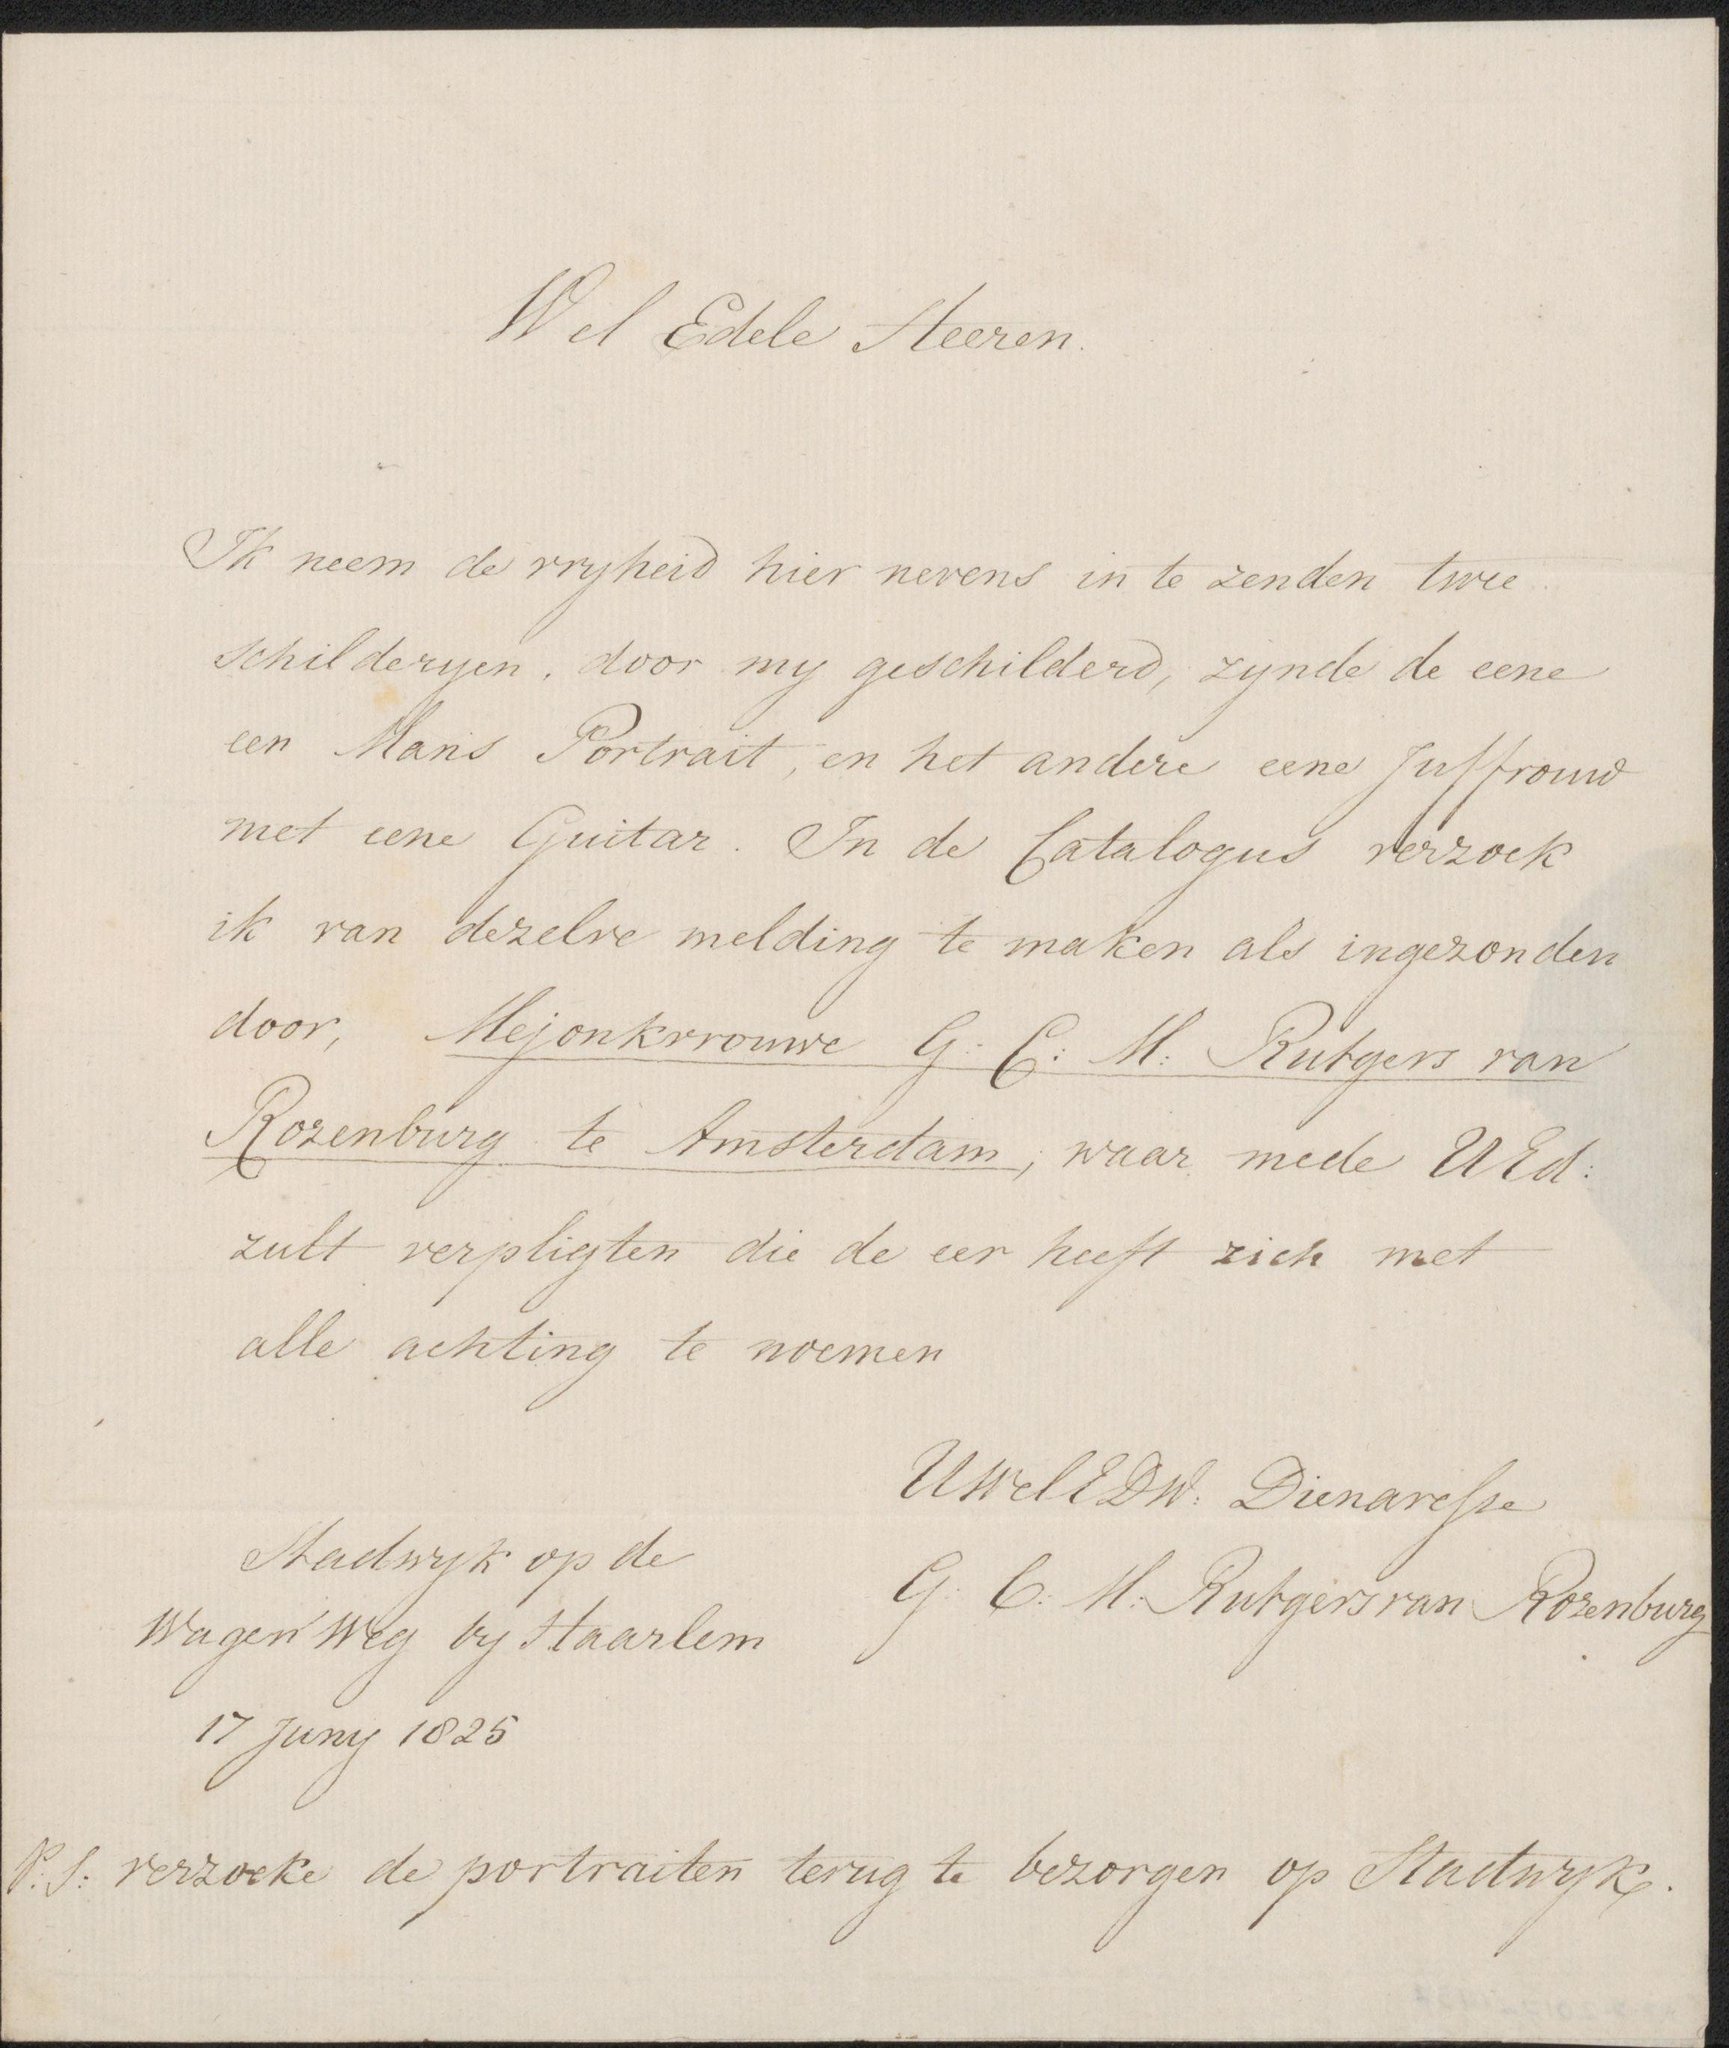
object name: letter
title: Brief aan de Commissie van de Tentoonstelling van Levende Meesters in Haarlem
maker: jonkvrouw geertruida catharina magdalena rutgers van rozenburg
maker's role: painter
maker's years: 1800-1859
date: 1825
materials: ink, paper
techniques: pen, writing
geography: haarlem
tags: painting (including book-illumination, miniature-painting), exhibition ~ art, historical persons (portraits and scenes from the life)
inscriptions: watermark